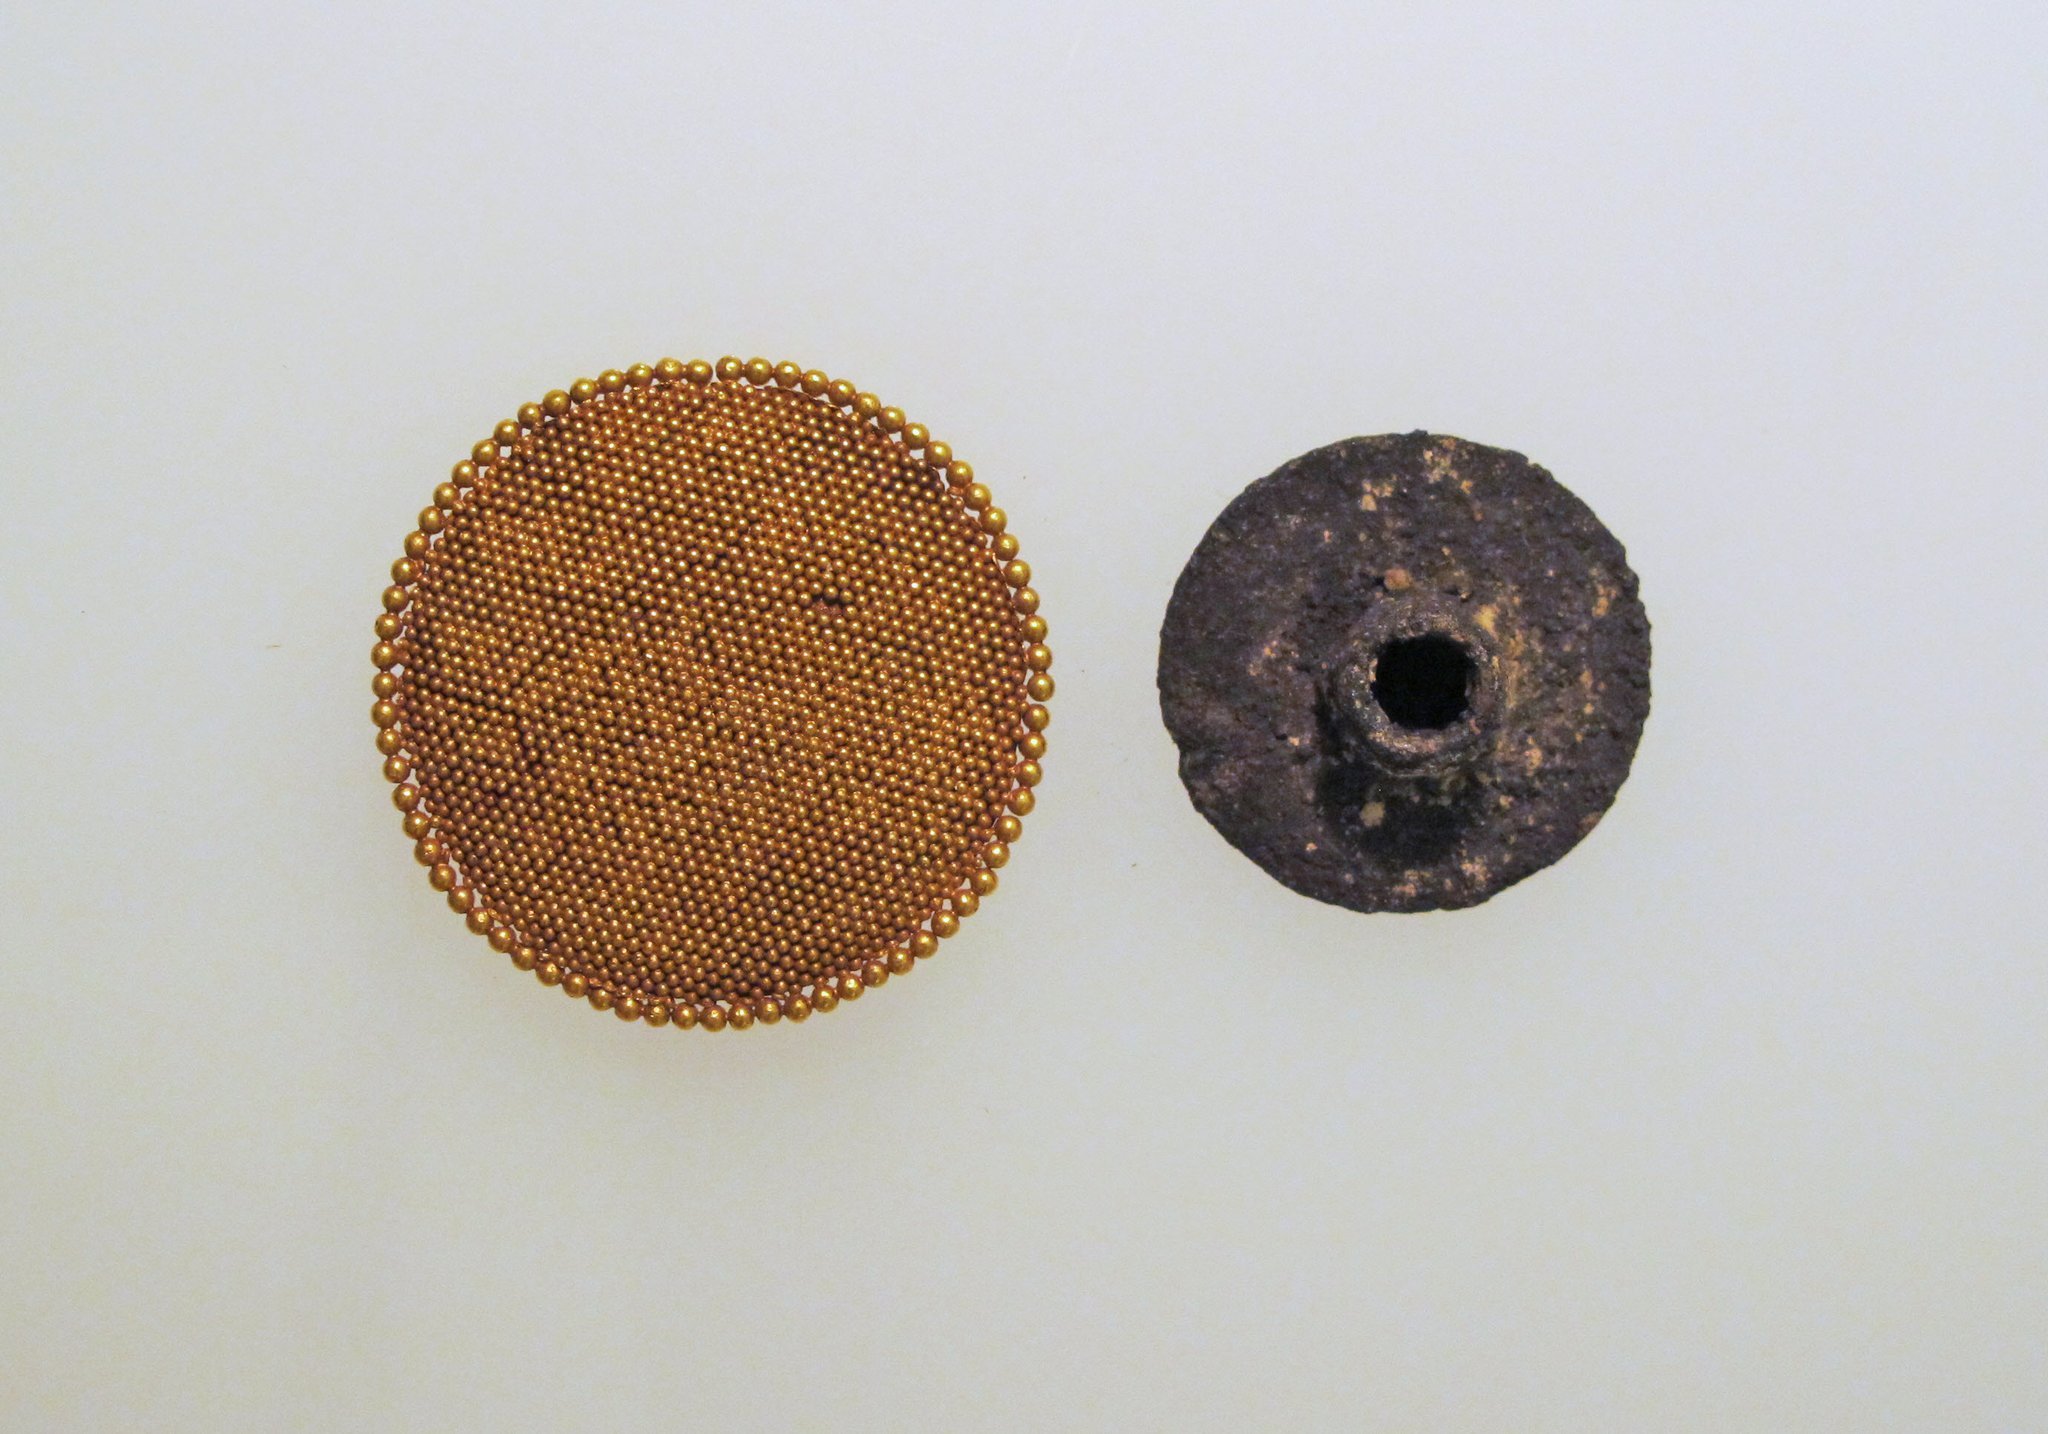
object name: earring with disc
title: Earring disc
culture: cypriot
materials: gold